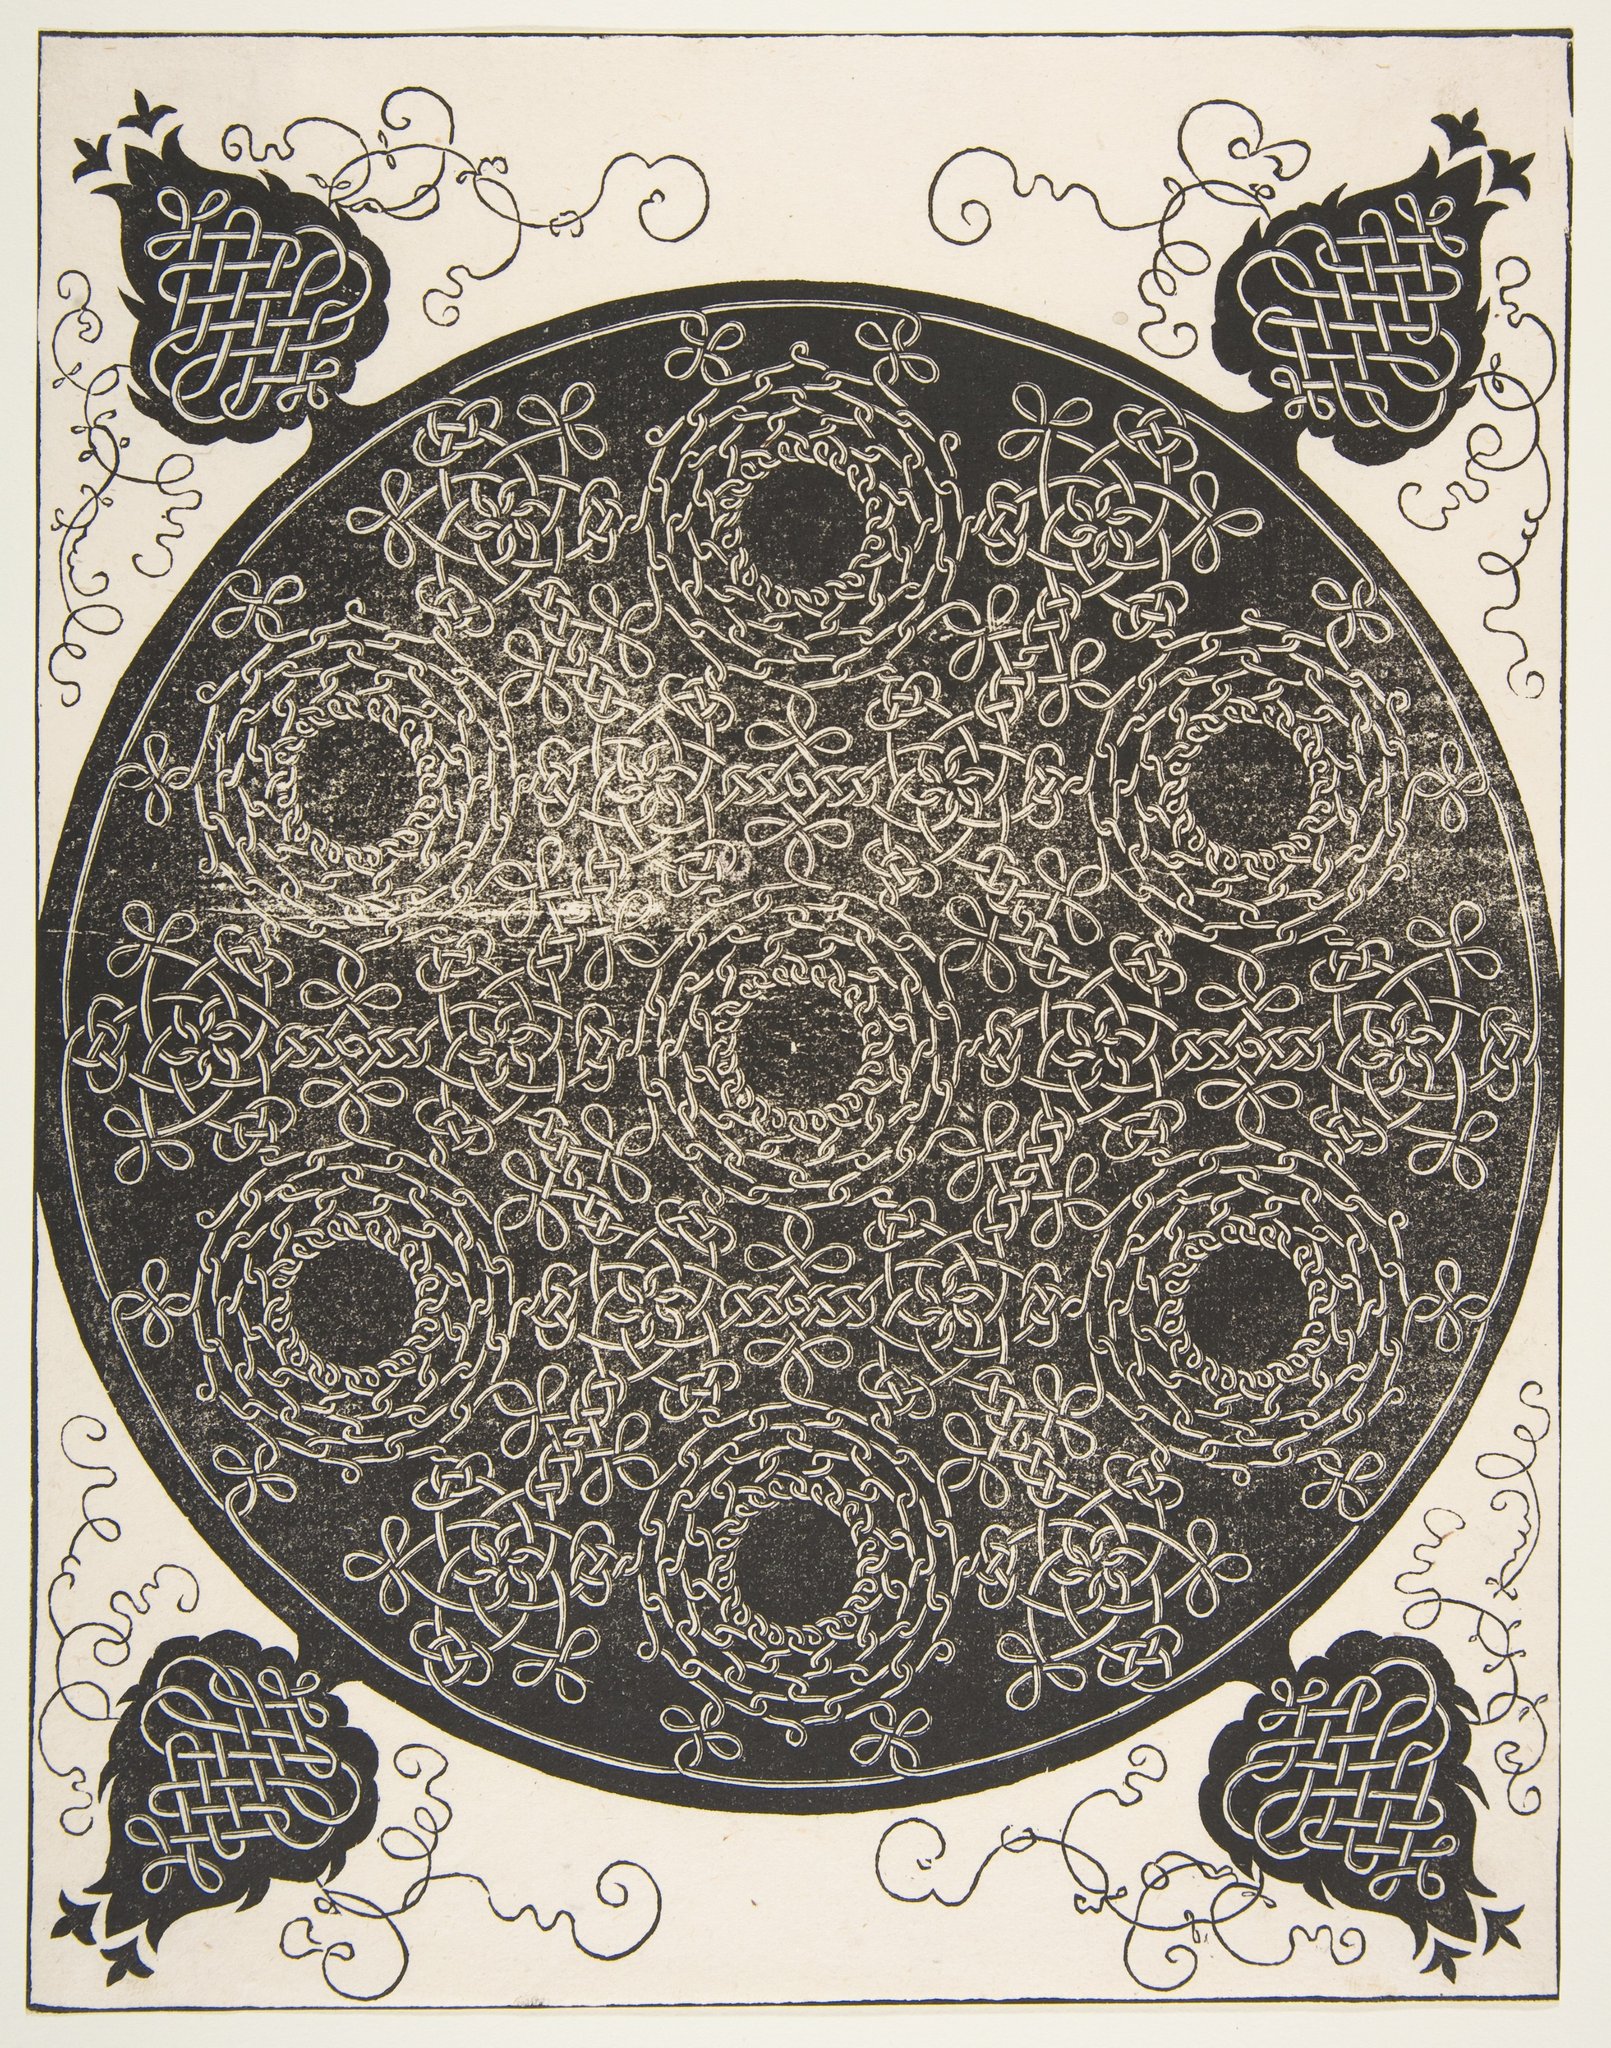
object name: collection ornament architecture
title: “The Sixth Knot”. Interlaced Roundel with Seven Wreaths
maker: albrecht dürer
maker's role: artist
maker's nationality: german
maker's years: 1471-1528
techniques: woodcut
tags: ornament,wreaths